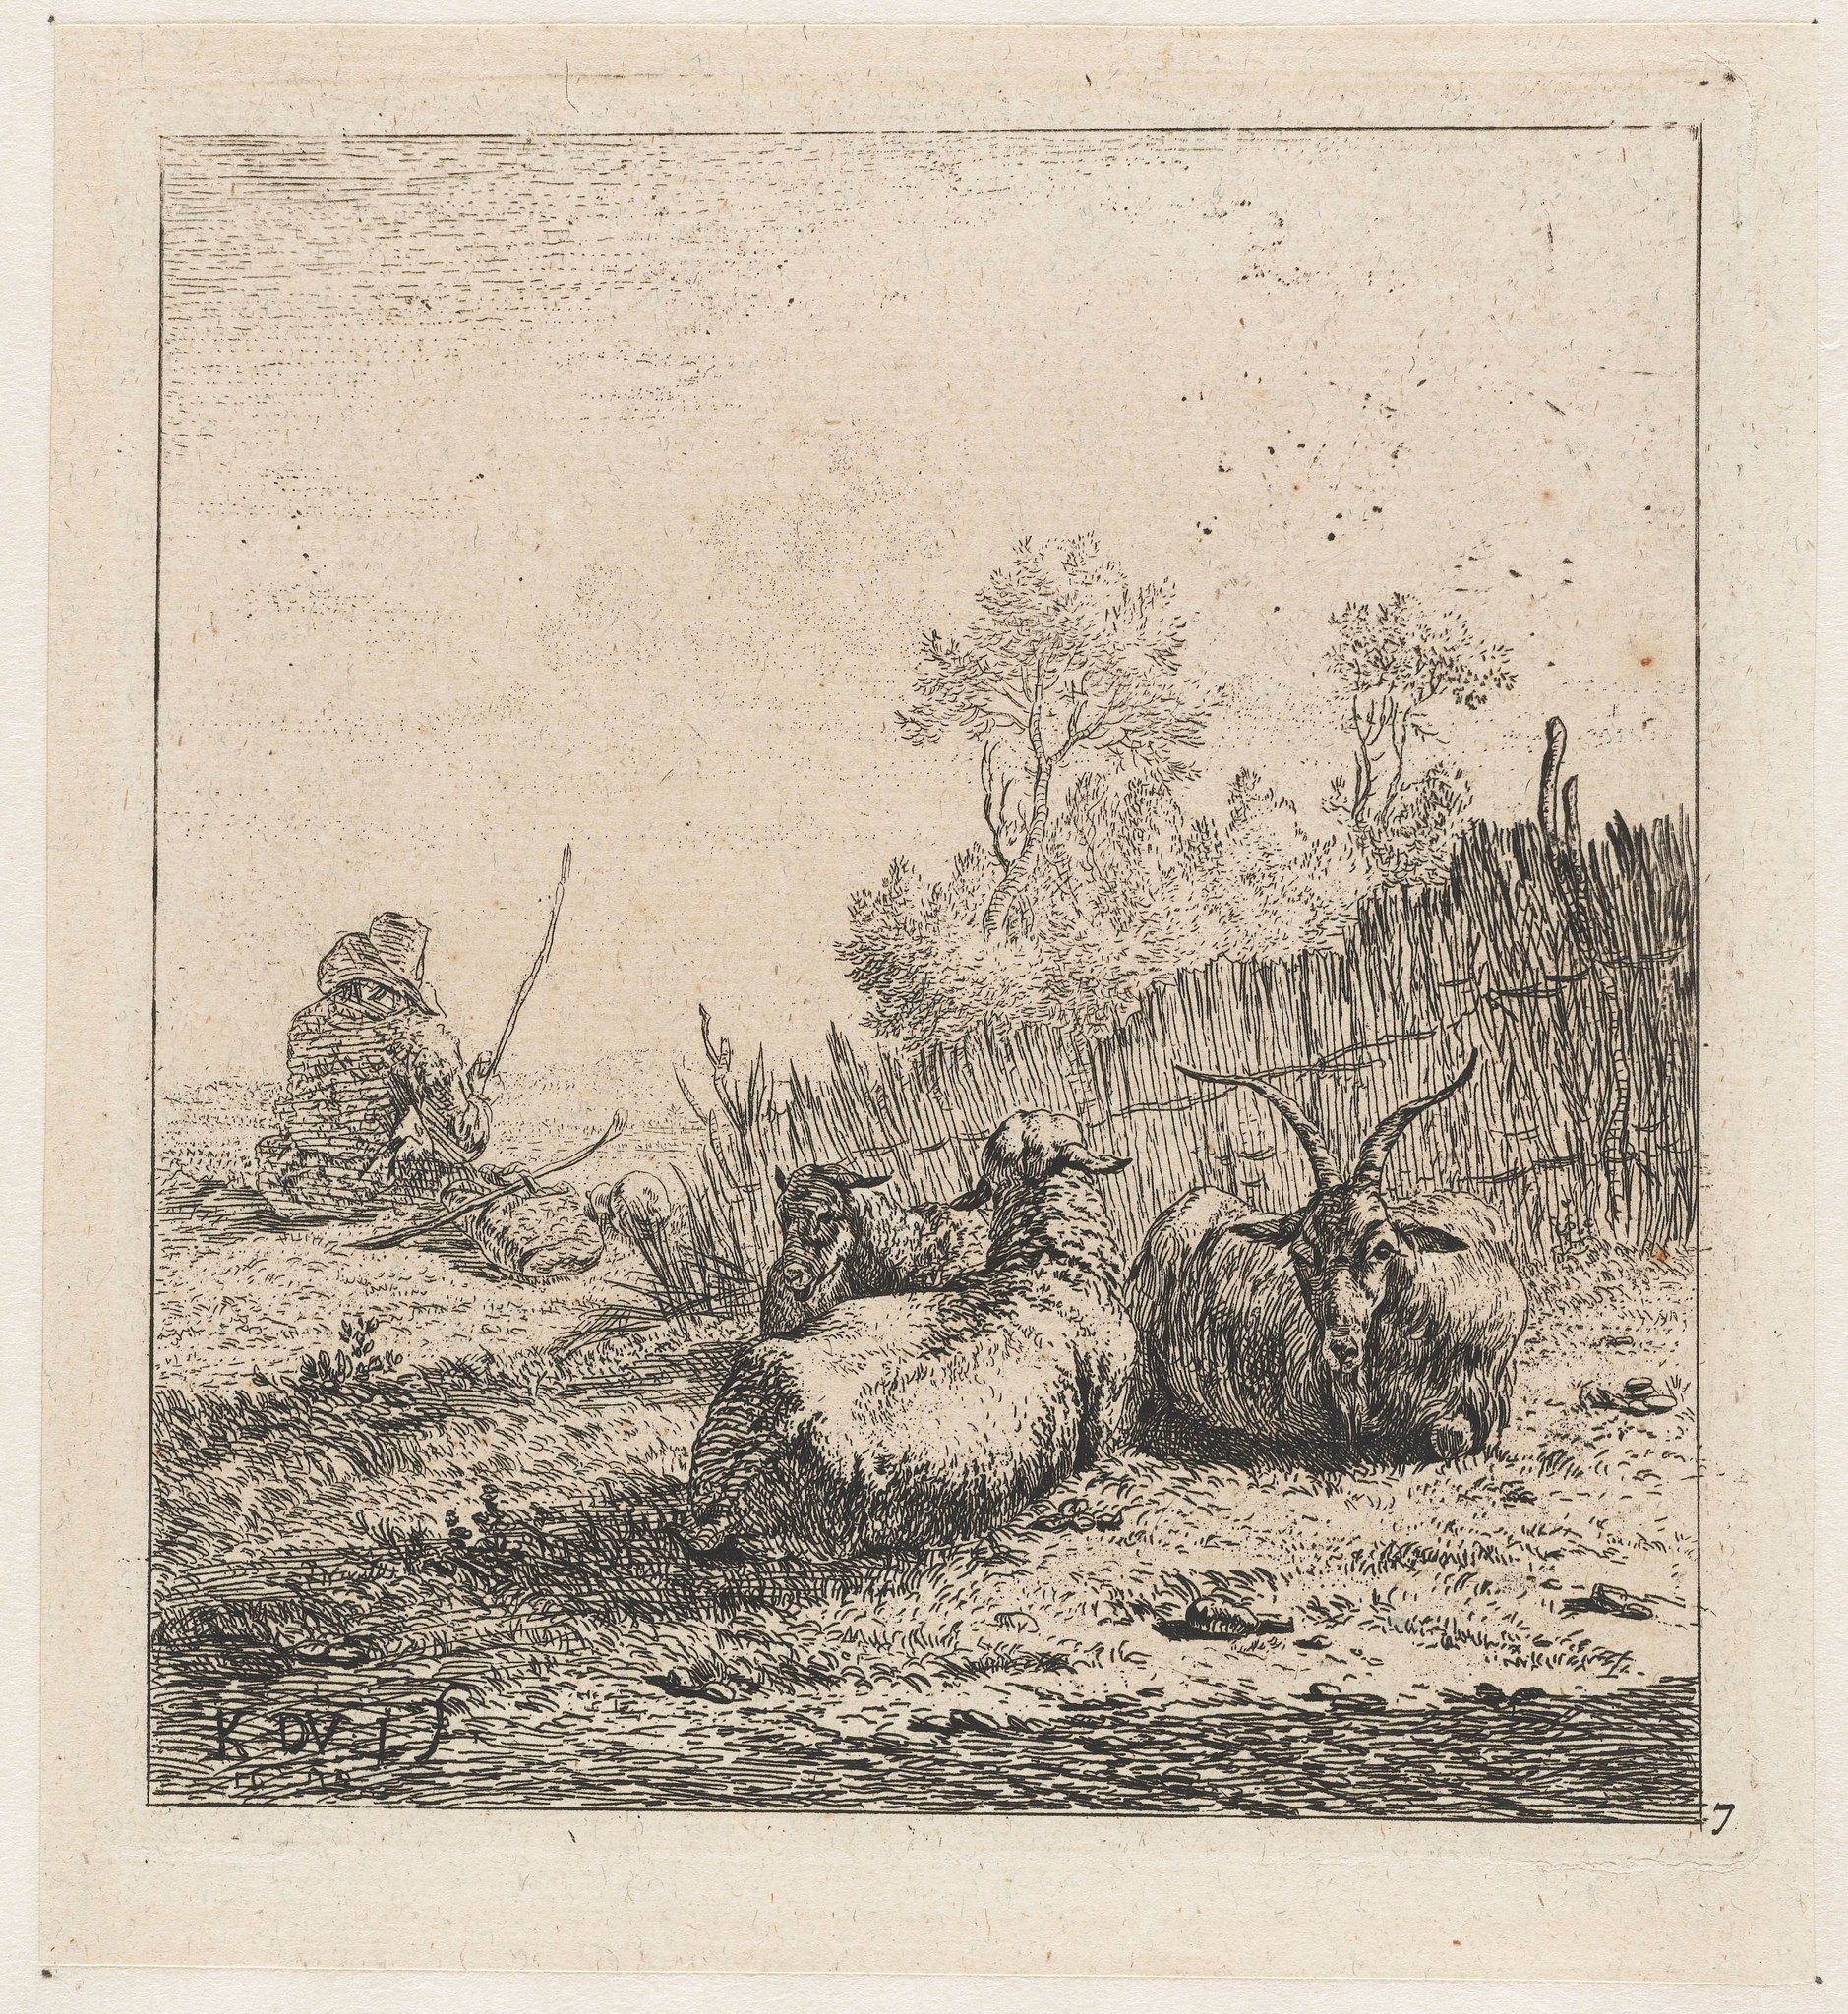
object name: print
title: Geit en twee schapen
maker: karel du jardin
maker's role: draughtsman, painter, print maker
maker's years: 1626-1678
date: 1652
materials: paper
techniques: etching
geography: amsterdam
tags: sheep, goat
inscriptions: date